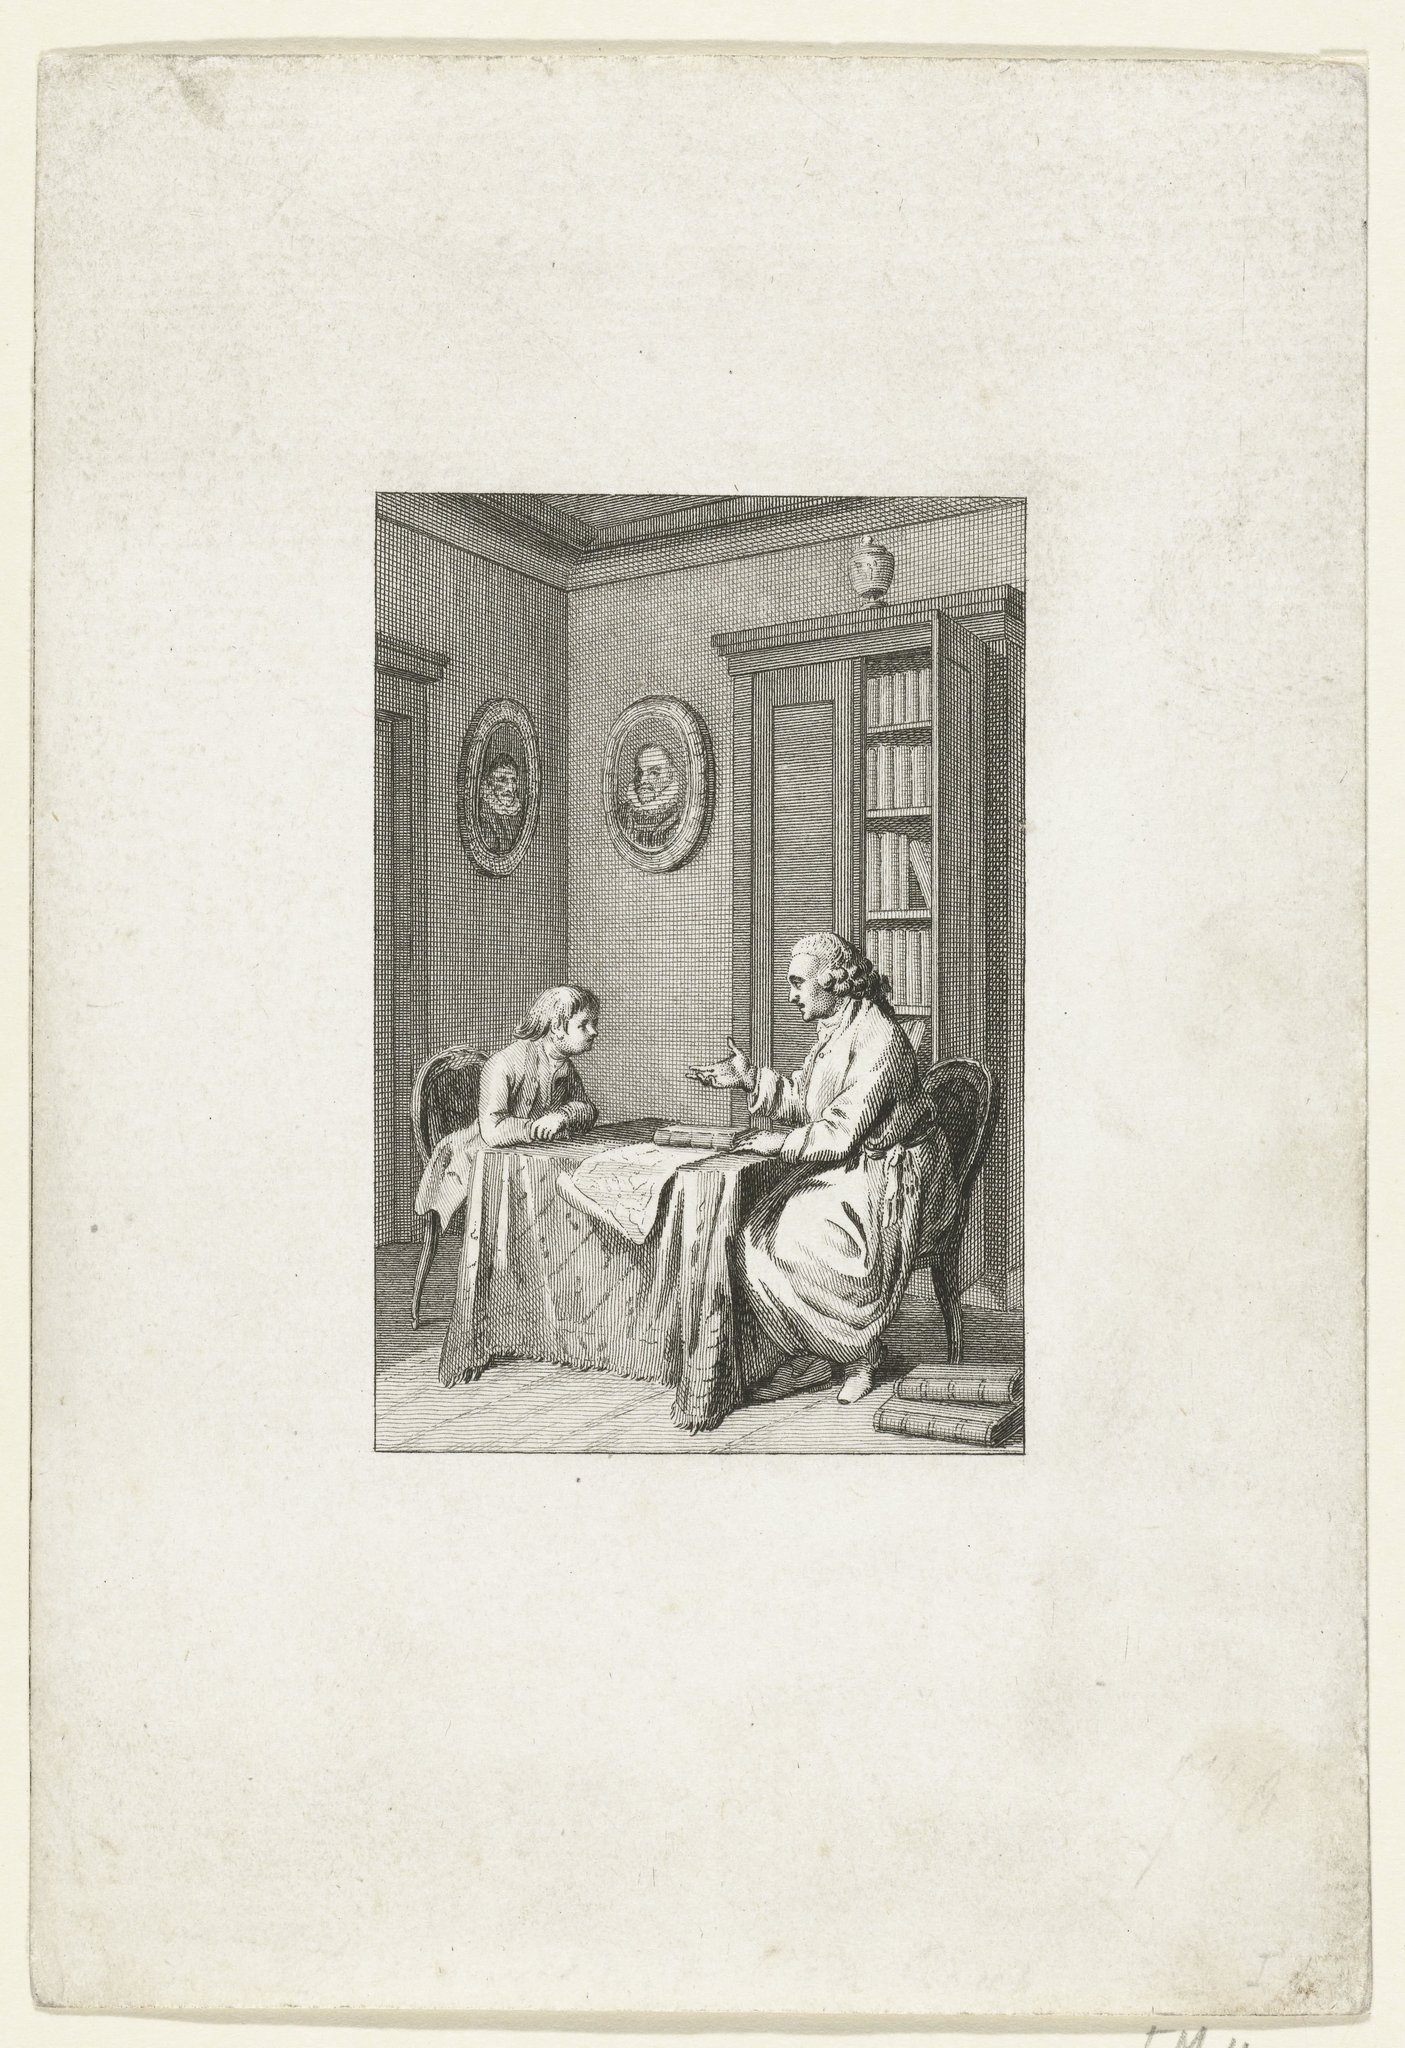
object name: titelprent, frontispice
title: Titelprent uit J. Fokke's Geschiedenissen der Vereenigde Nederlanden voor de vaderlandsche jeugd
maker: reinier vinkeles (i)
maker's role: draughtsman, print maker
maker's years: 1741-1816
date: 1780-1783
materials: paper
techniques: etching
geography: netherlands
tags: reading to somebody, netherlands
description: Titelprent uit J. Fokke's Geschiedenissen der Vereenigde Nederlanden voor de vaderlandsche jeugd. Proefdruk voor de letter. In een huiskamer vertelt een oudere man aan een jongen over de geschiedenis van Nederland.